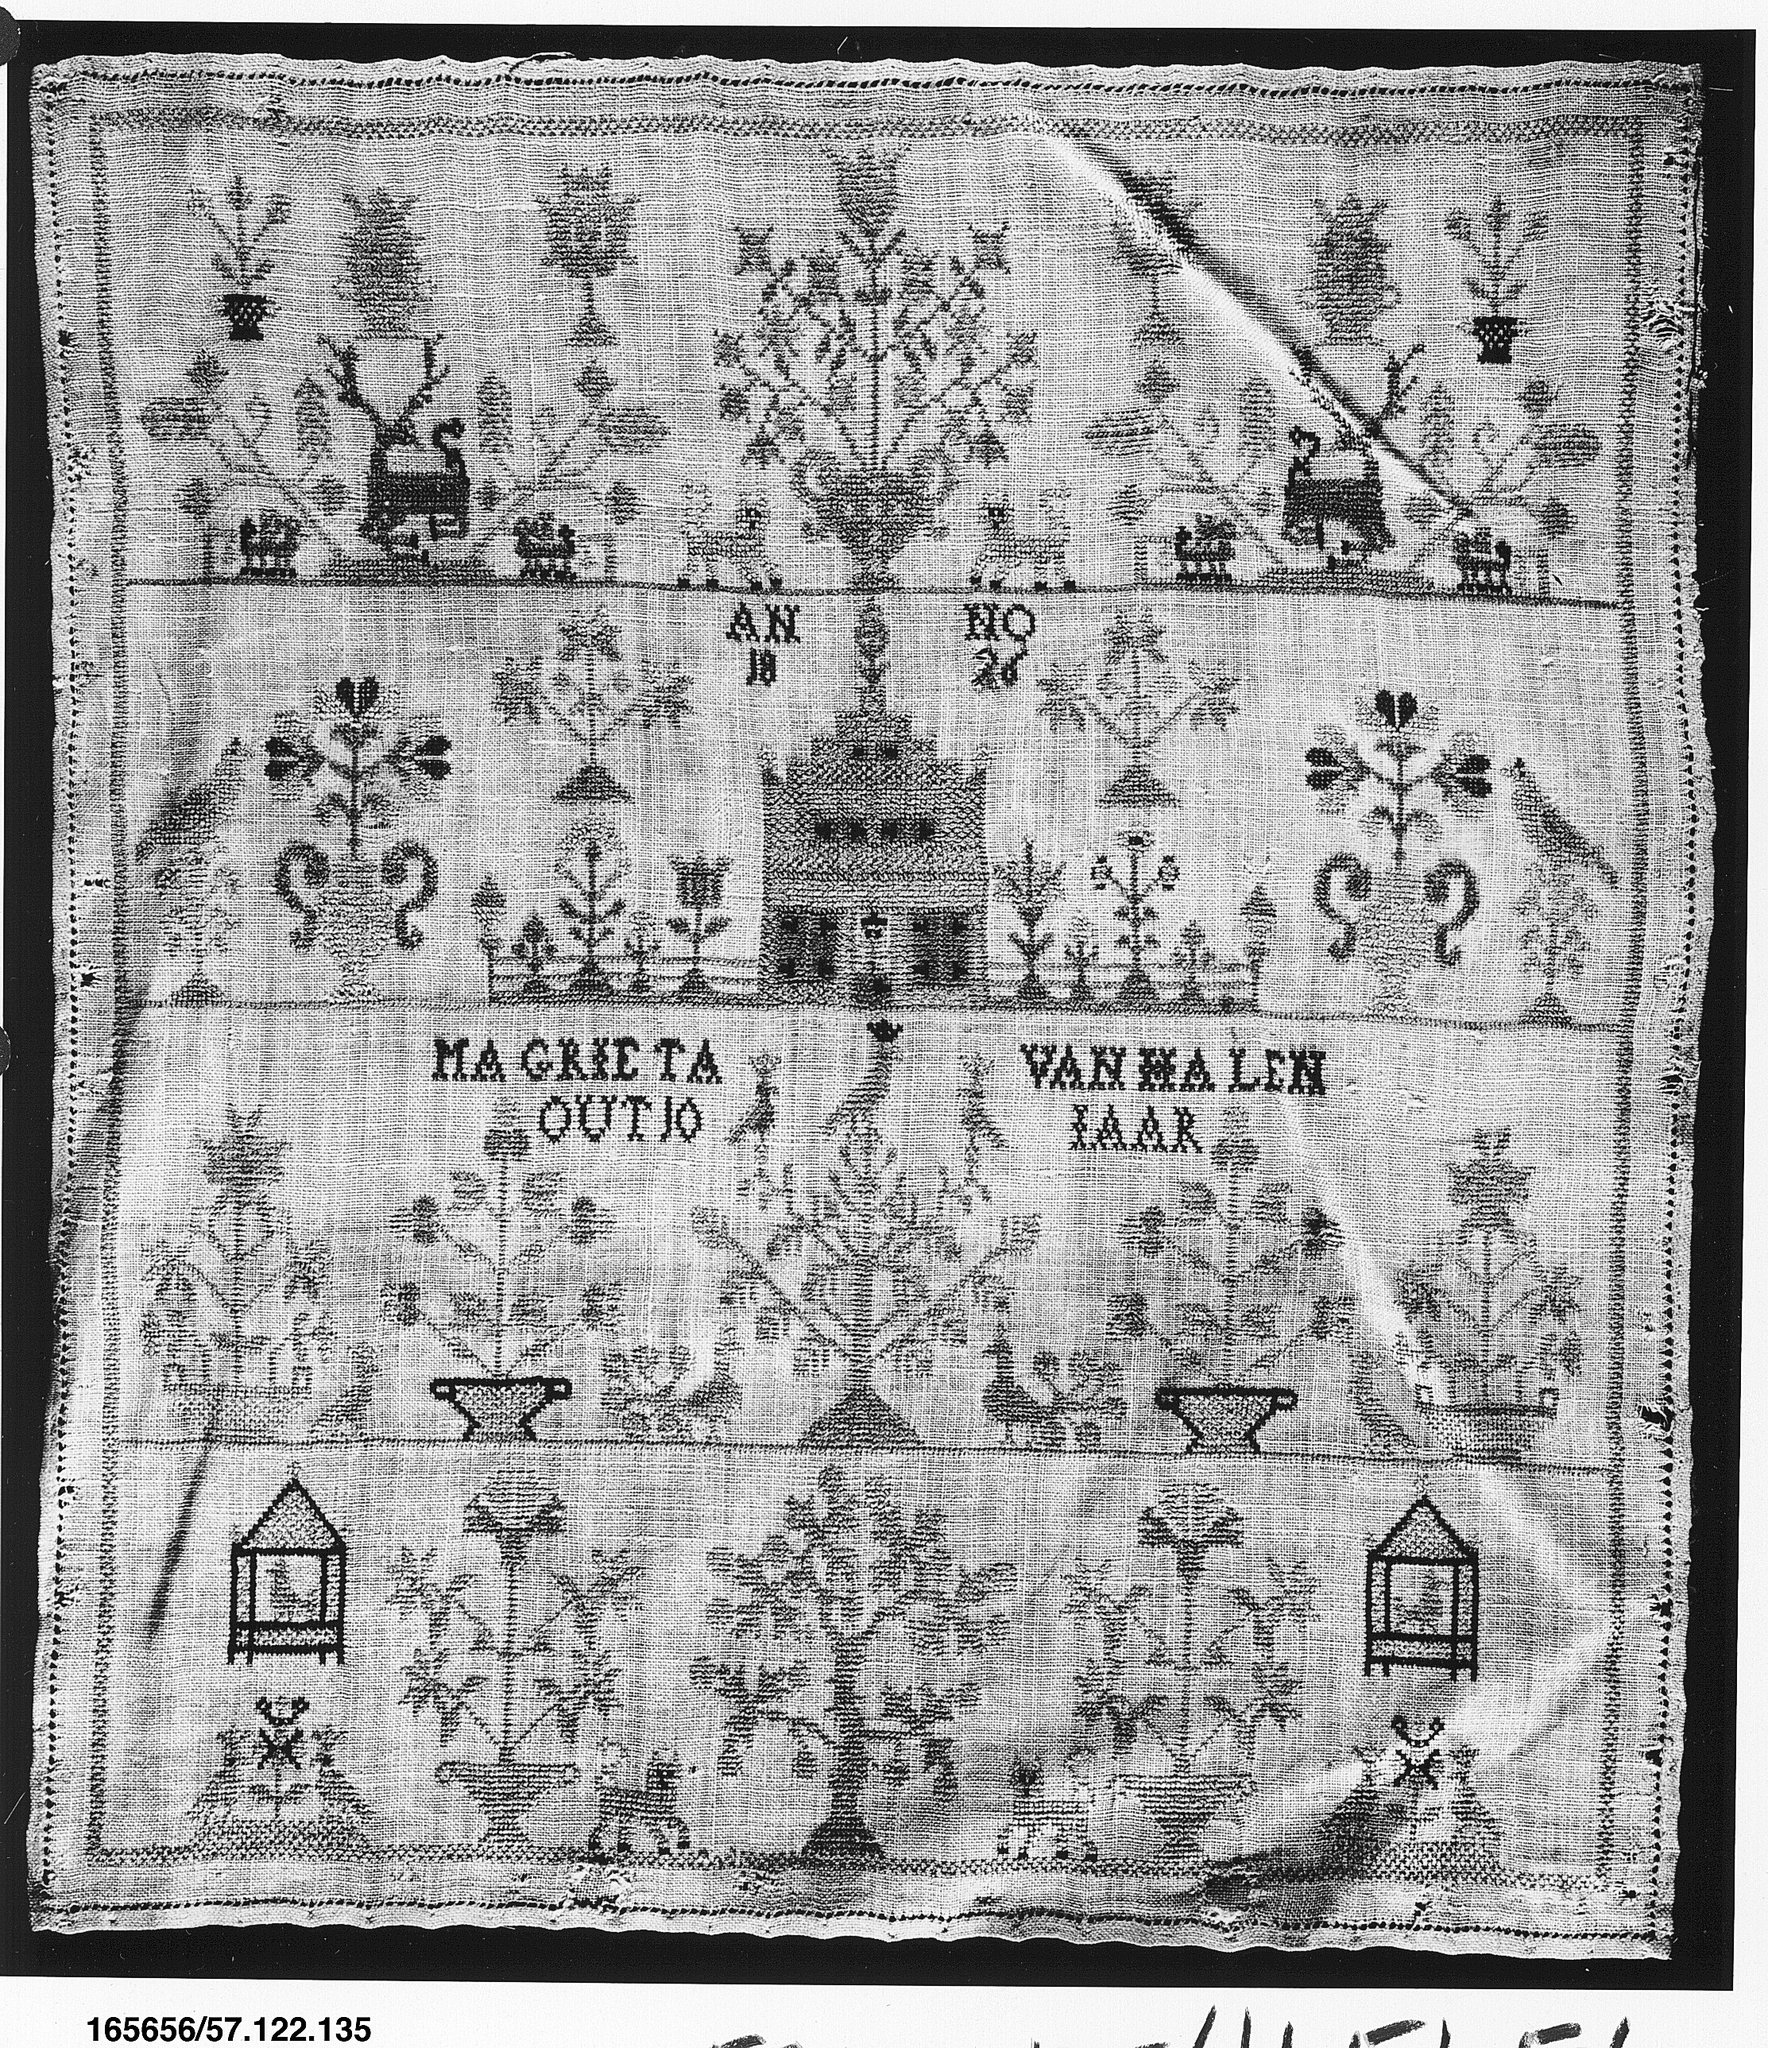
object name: sampler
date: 1826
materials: linen, silk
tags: houses,trees